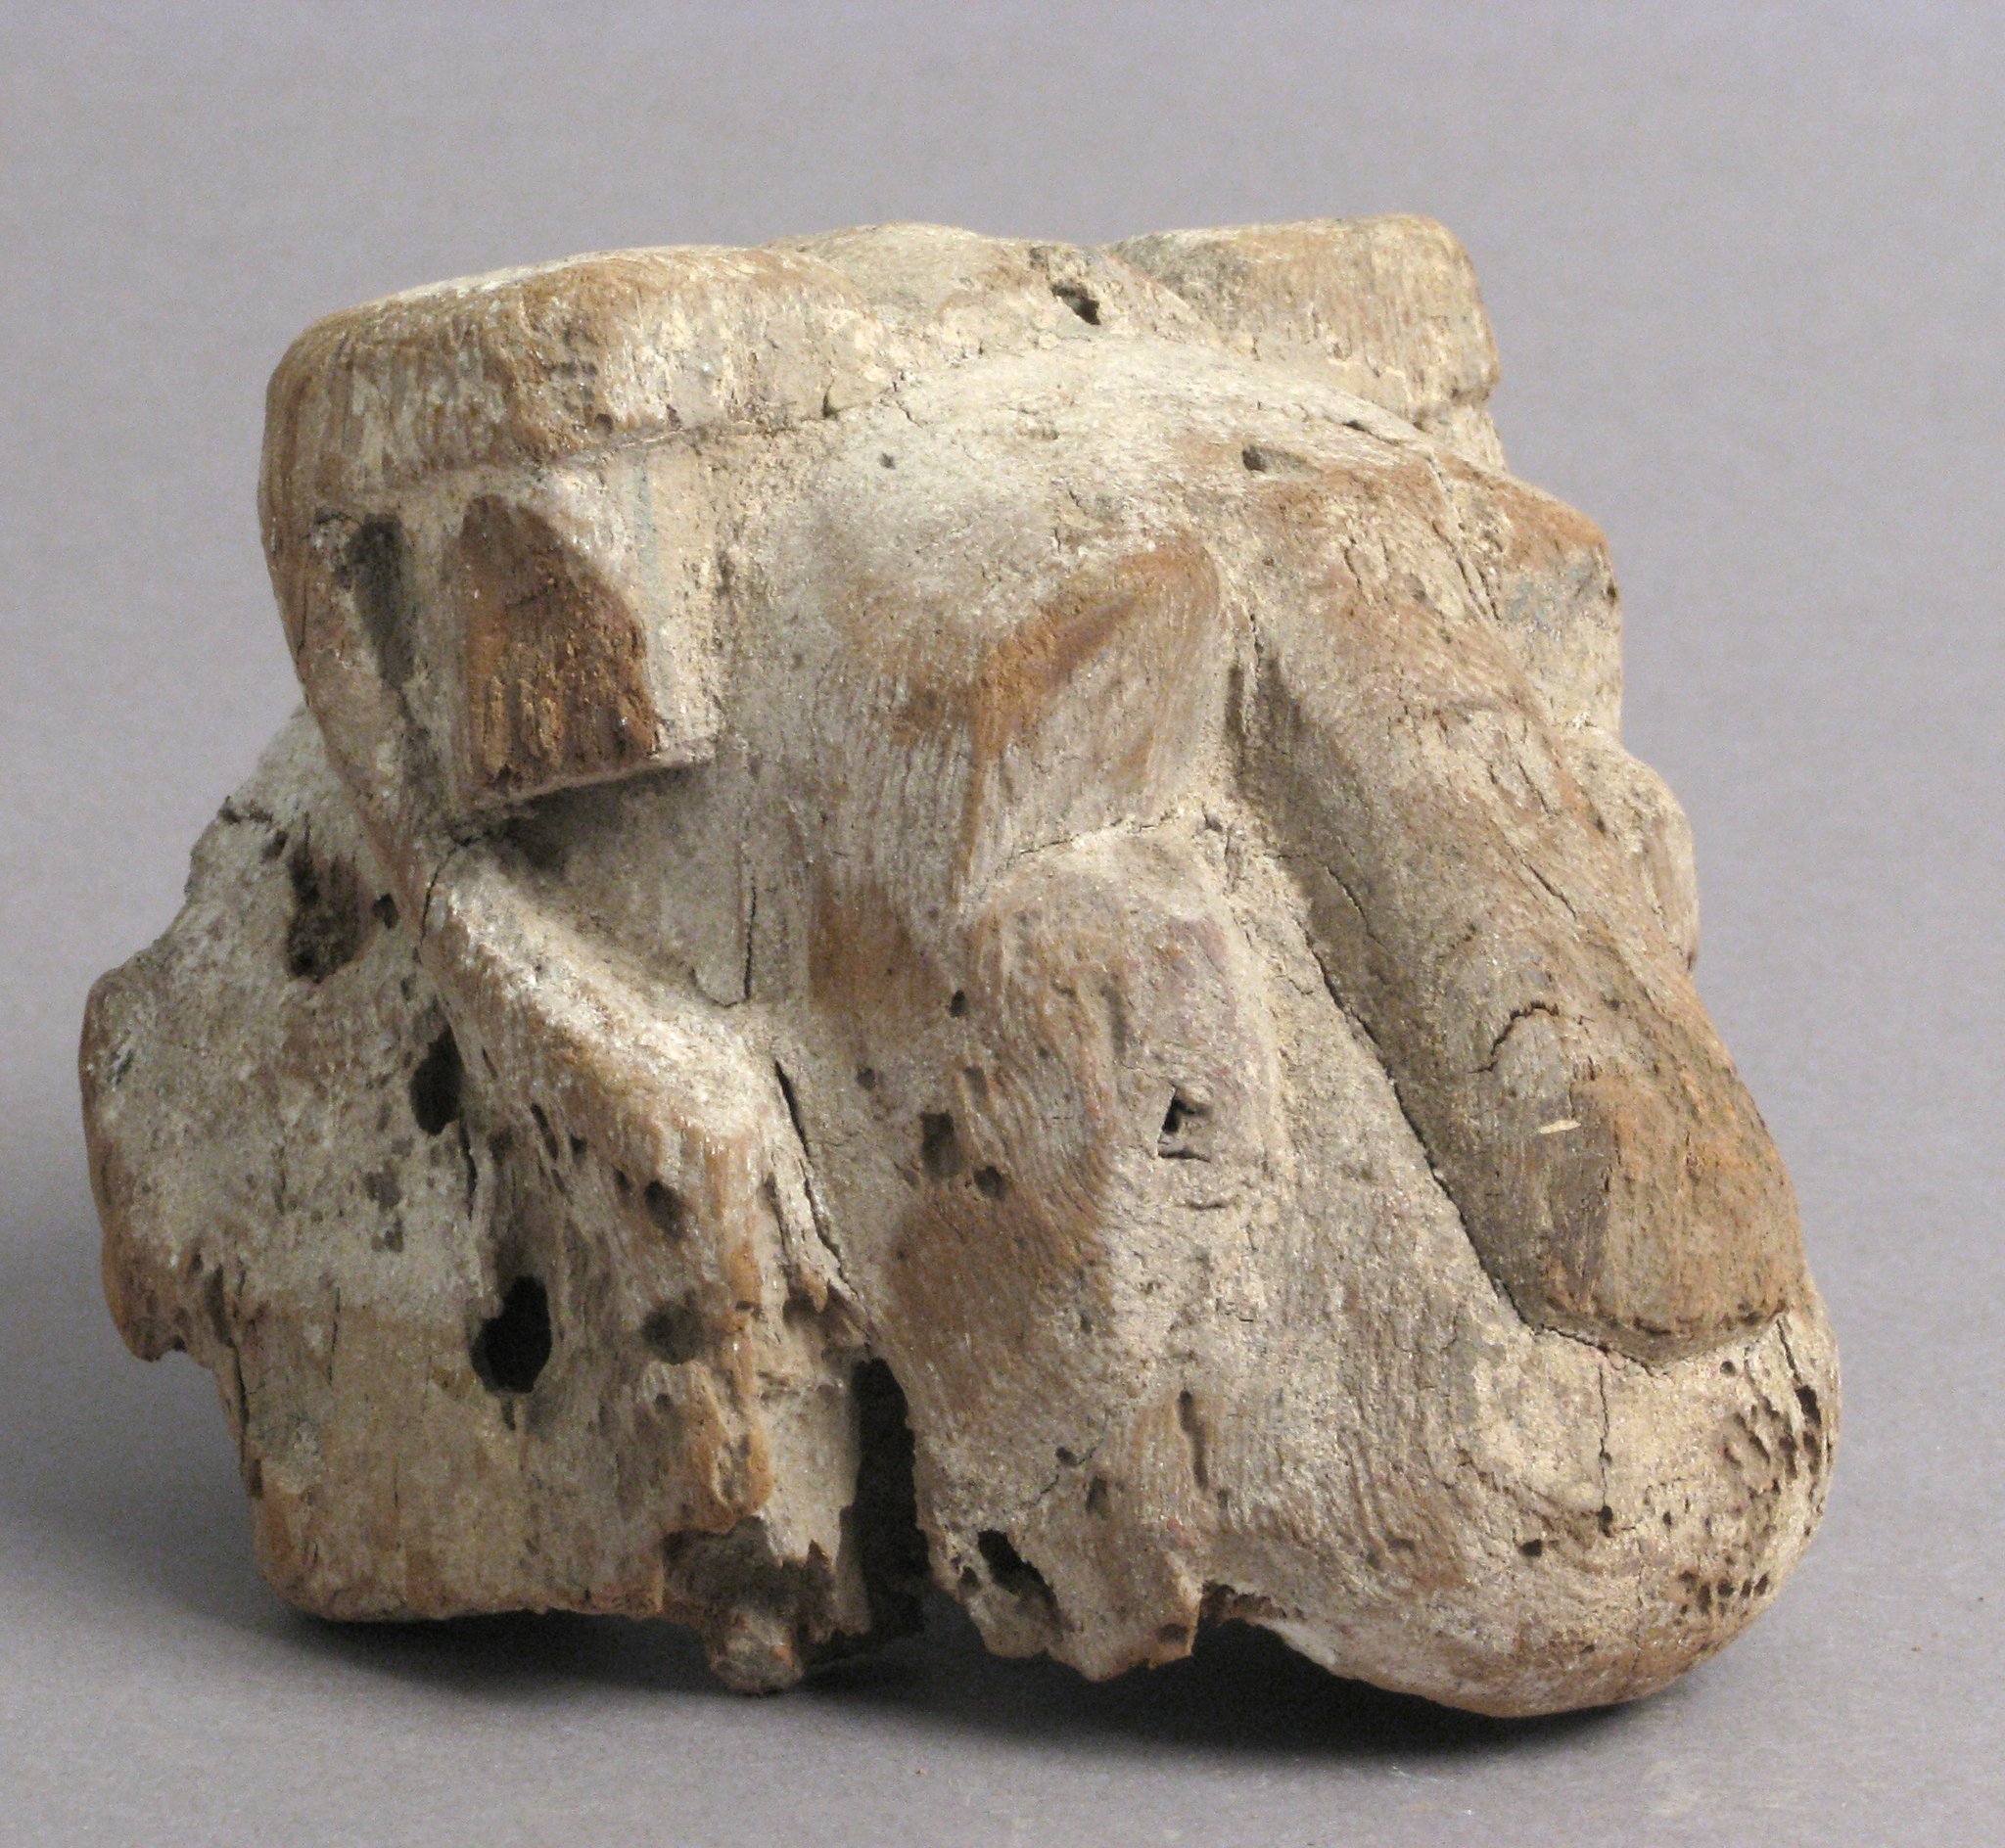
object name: statuette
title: Head of Lion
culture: coptic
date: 301-700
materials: wood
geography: egypt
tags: lions